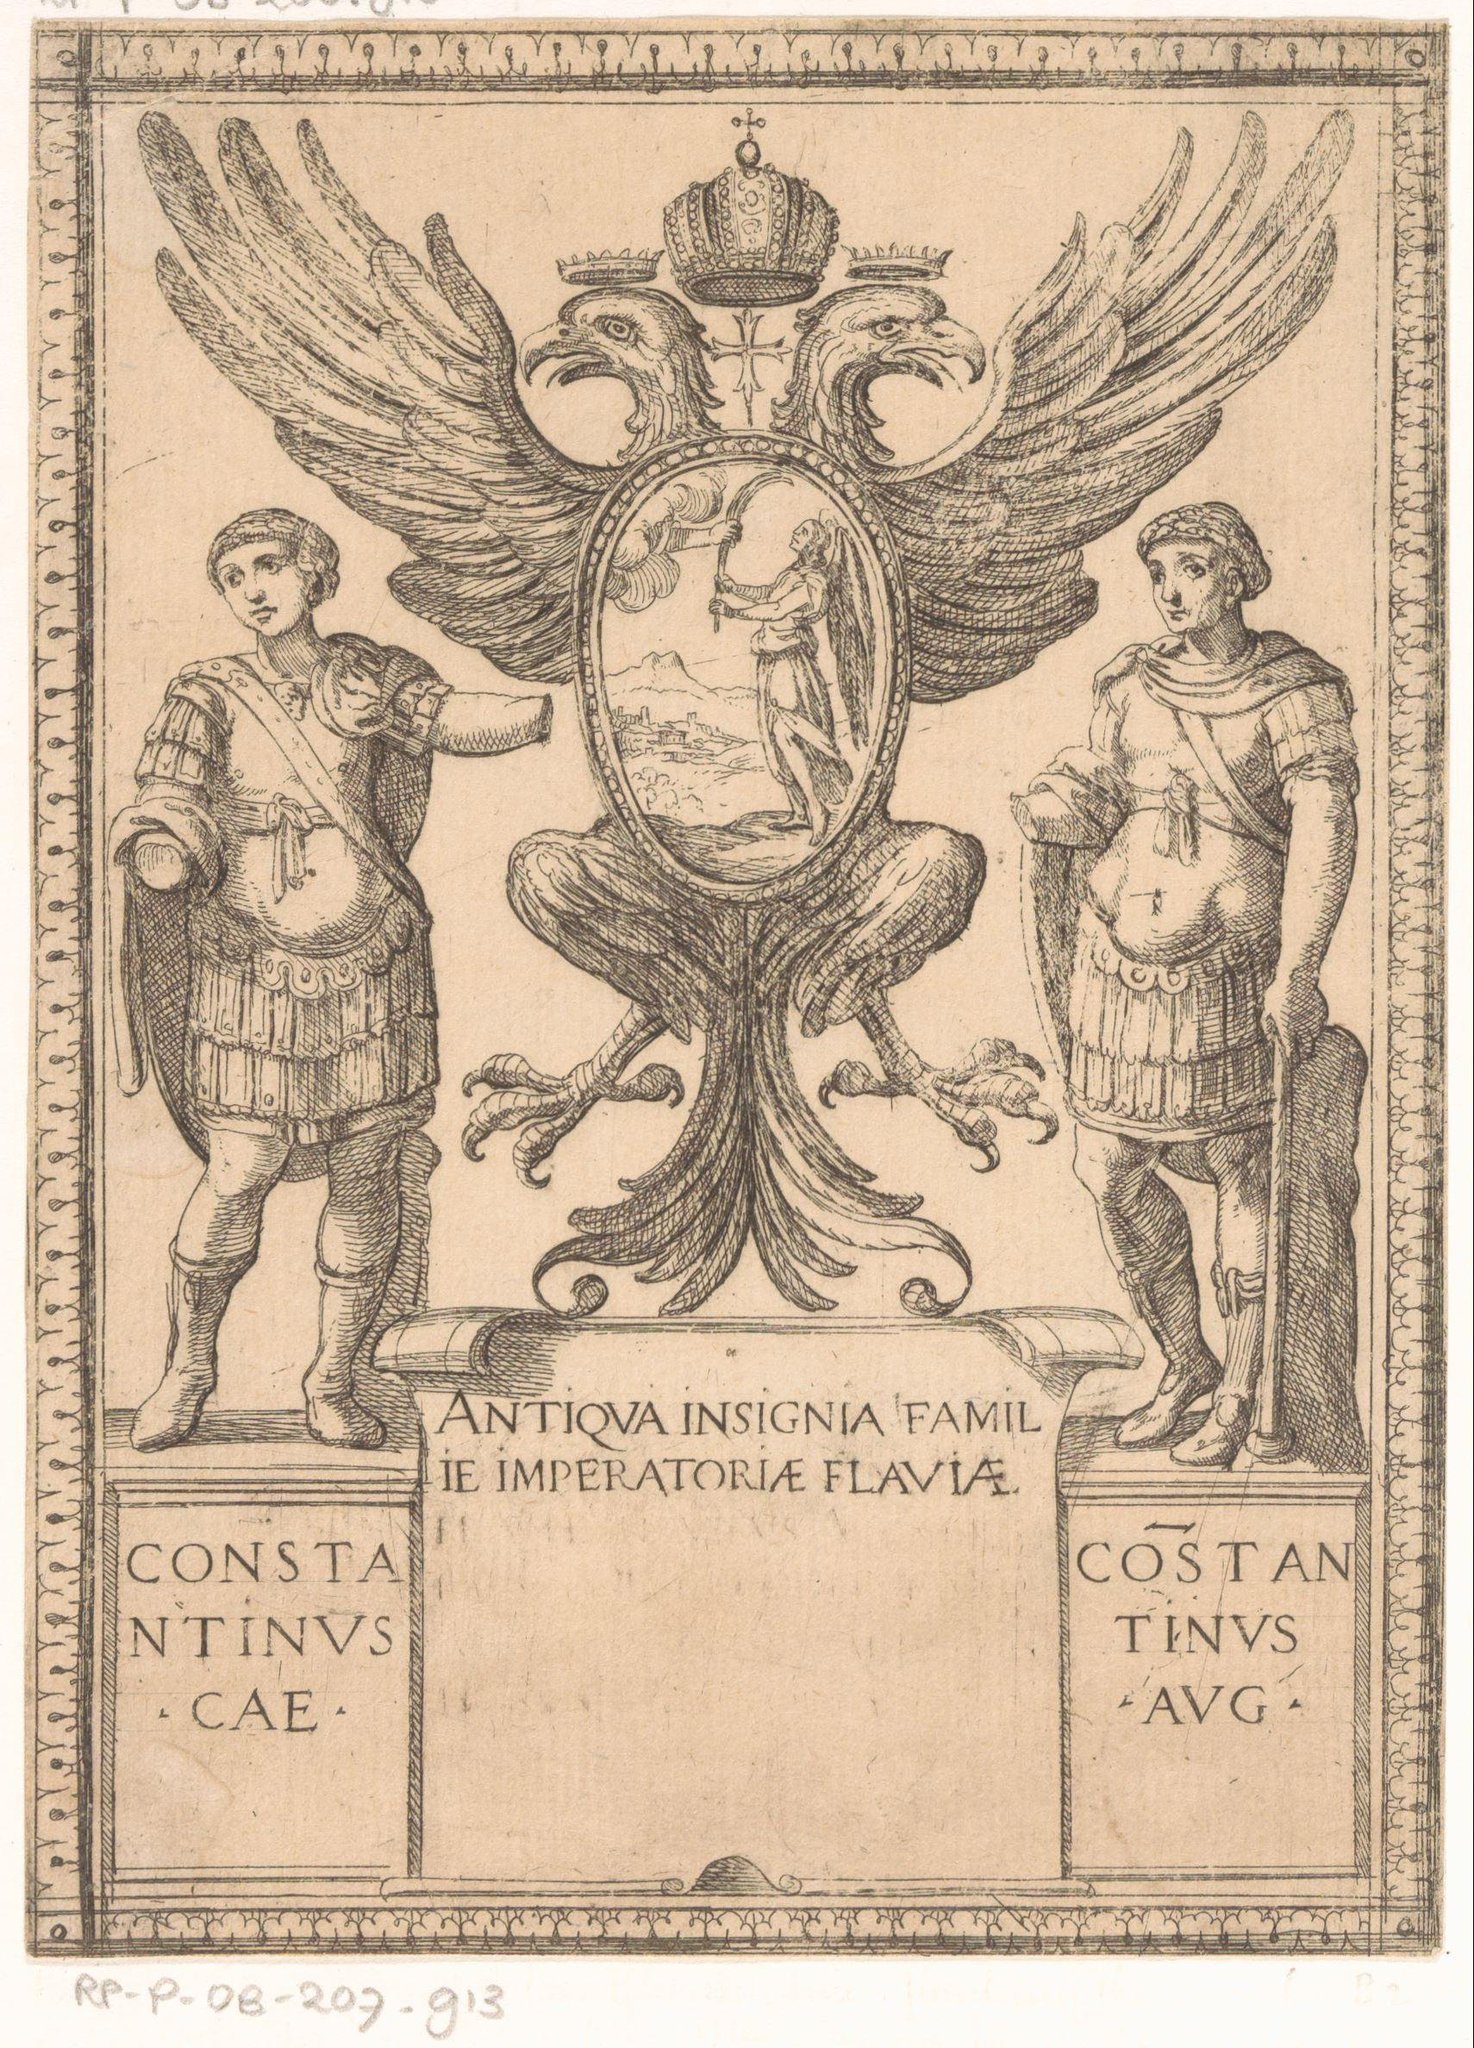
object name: print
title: Isagogia historia de Constantino max: imperatore instatuta militie angelicae aureatae Constantinianae sub titulo magni martyris S Georgii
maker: antonio tempesta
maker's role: draughtsman, painter, print maker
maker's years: 1555-1630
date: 1565-1630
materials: paper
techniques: etching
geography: italy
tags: coat of arms (symbol of sovereignty), historical persons, piece of sculpture, reproduction of a piece of sculpture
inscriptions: collector's mark: Lugt 240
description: Het familiewapen van de Flaviërs wordt aan weerszijden geflankeerd door een sculptuur van keizer Constantijn de Grote. Opschriften in het Latijn op de basementen.